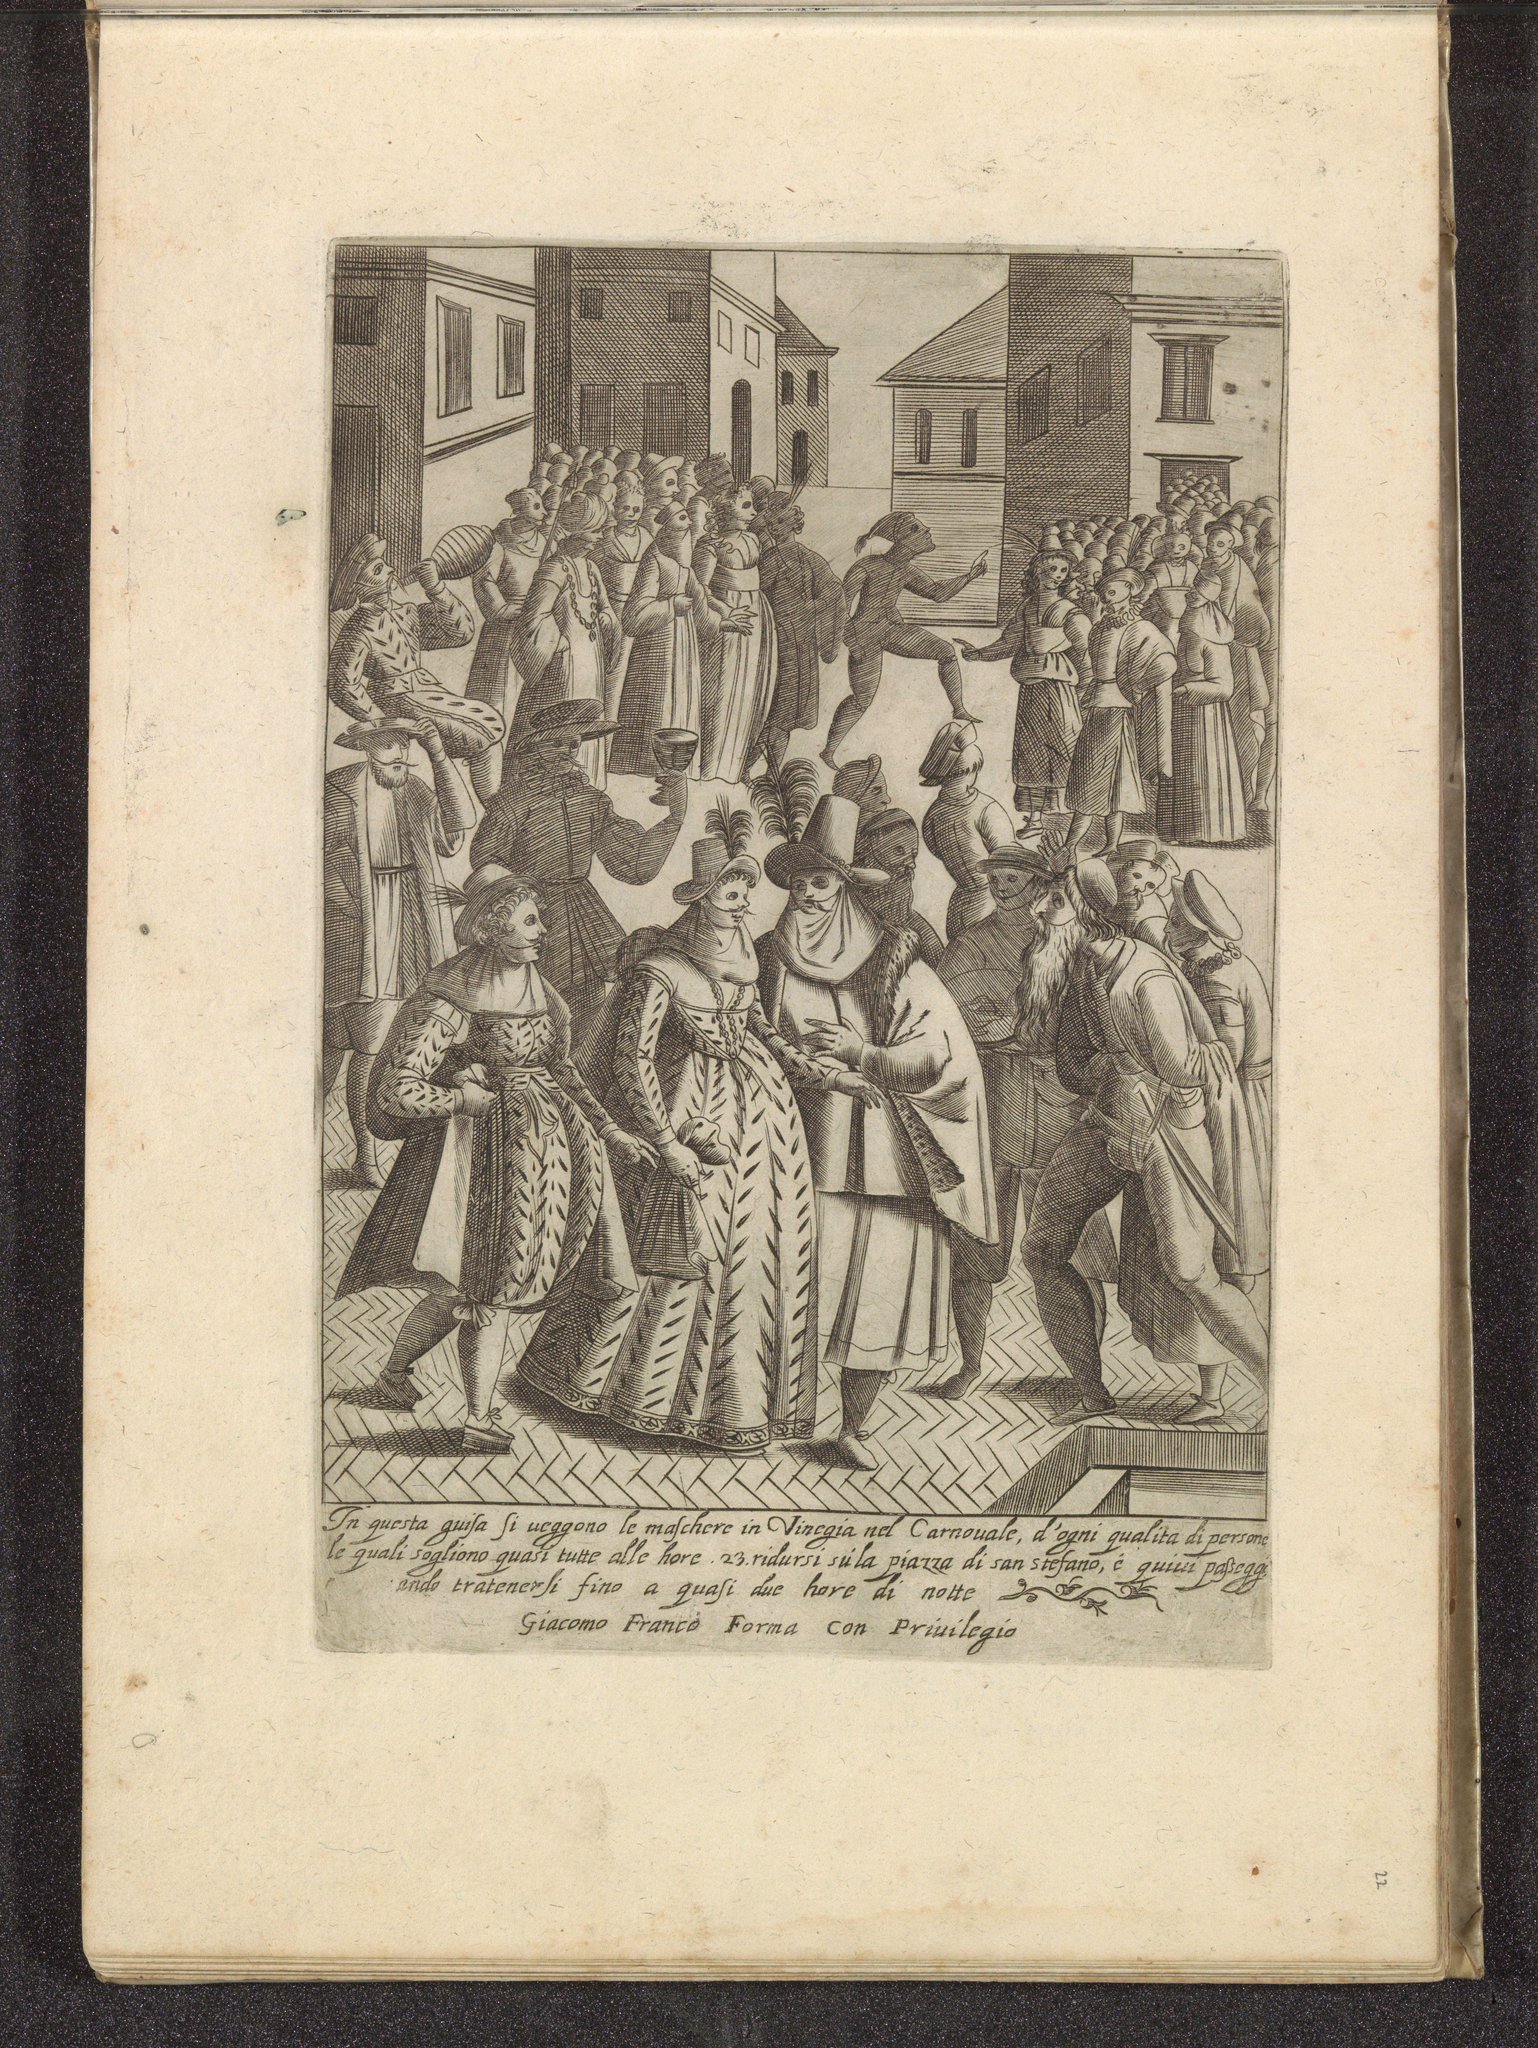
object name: print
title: Scènes uit het Venetiaanse leven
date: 1610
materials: paper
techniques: engraving, intaglio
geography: venice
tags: mask, festivities (+ costume party ~ festive activities), venice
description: Gemaskerde mannen en vrouwen op straat in Venetië tijdens het carnaval. Drieregelige Italiaanse tekst in ondermarge. De prent maakt deel uit van een album.